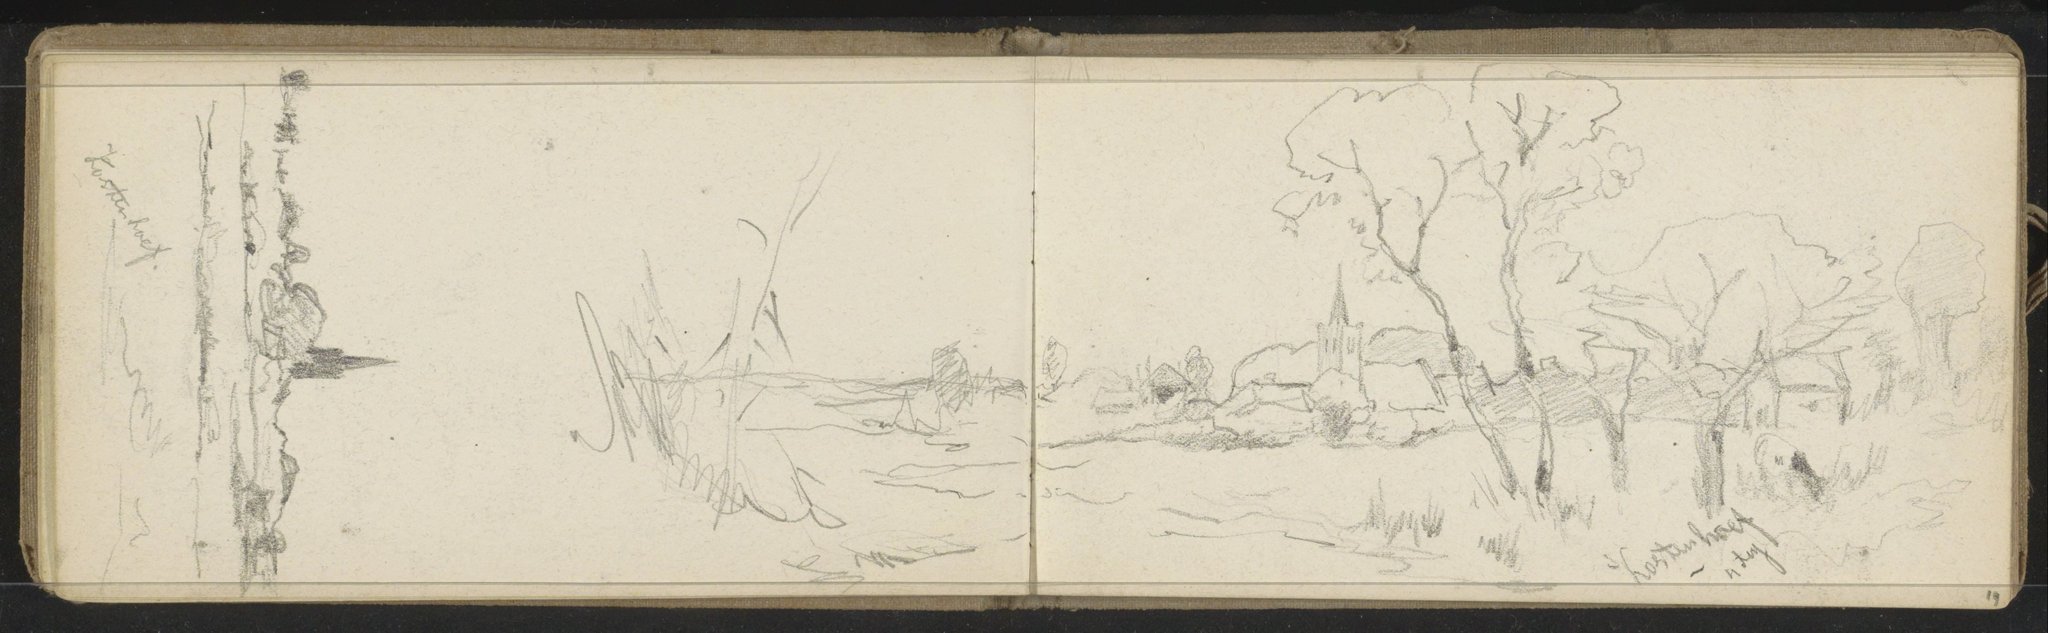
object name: sketchbook leaf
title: Gezichten op Kortenhoef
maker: willem cornelis rip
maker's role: draughtsman, painter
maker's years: 1856-1922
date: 1808-1895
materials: paper, pencil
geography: kortenhoef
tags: village, parts of church exterior and annexes: tower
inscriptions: date and inscription: ‘Kortenhoef/ Kortenhoef 4 Aug’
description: Onder andere de toren van de Nederlands Hervormde Kerk is te zien. Blad 18 verso en 19 recto uit een schetsboek met 39 bladen.